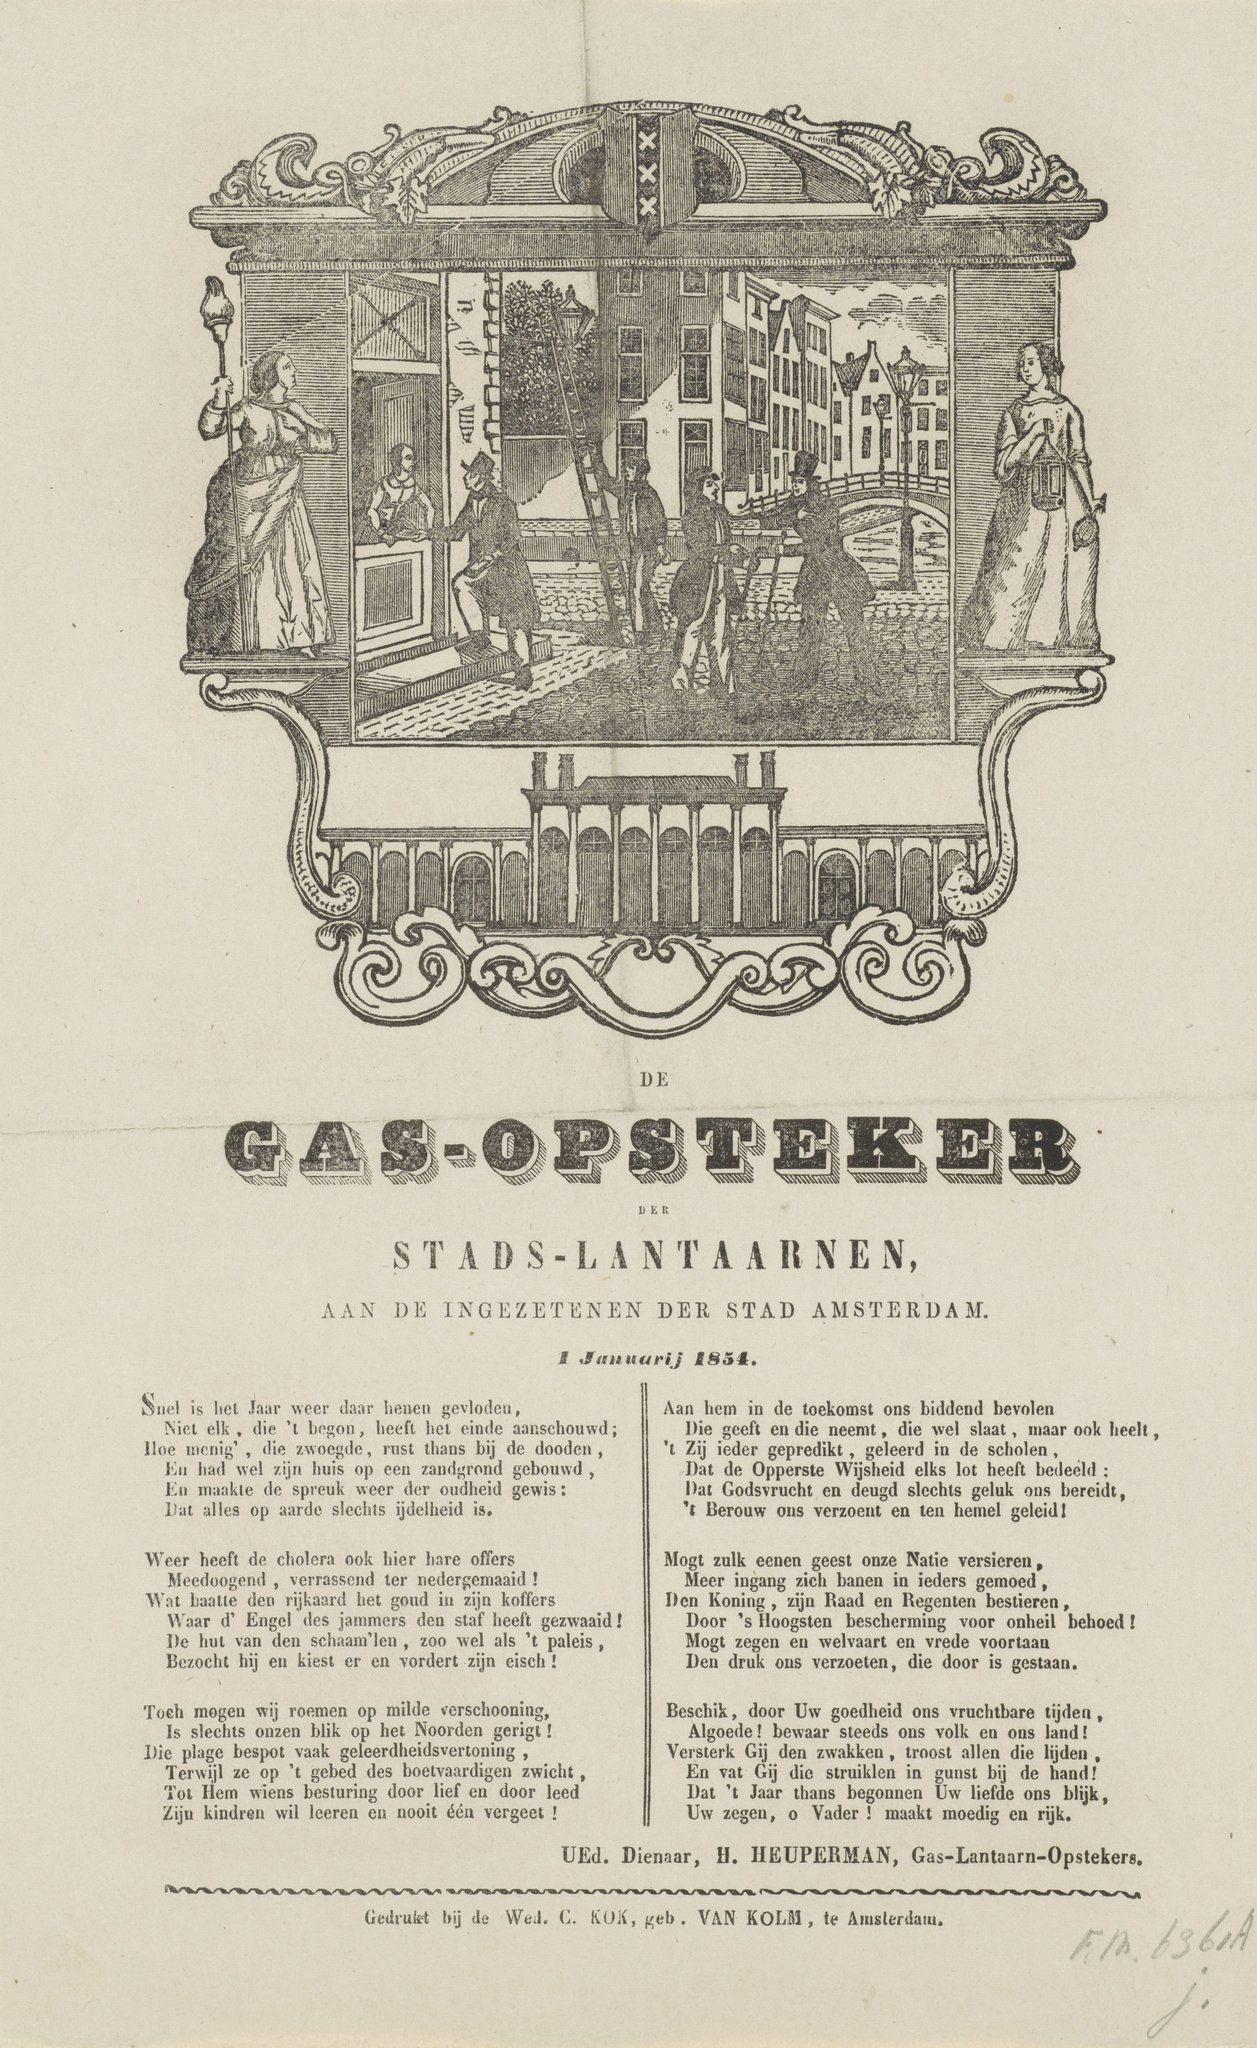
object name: new year card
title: Nieuwjaarswens van de gaslantaarnopstekers van Amsterdam voor het jaar 1854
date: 1853-1854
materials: paper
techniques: letterpress printing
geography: amsterdam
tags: gas-lamp (+ kindling a light; lit, burning light, lamp, candle), street lighting, street, amsterdam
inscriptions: collector's mark: Lugt 2228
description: Nieuwjaarswens van de Amsterdamse gaslantaarnopstekers voor het jaar 1854. Cartouche met een gezicht in een straat in Amsterdam waar enkele mannen bezig zijn de straatlantaarns aan te steken. Een andere man haalt geld op bij een huis. Links en rechts een staande vrouw met een fakkel en een olielantaarn, onderaan de Amsterdamse gasfabriek. Met gedicht in twee kolommen. Van de gaslantaarnopsteker: H. Heuperman.